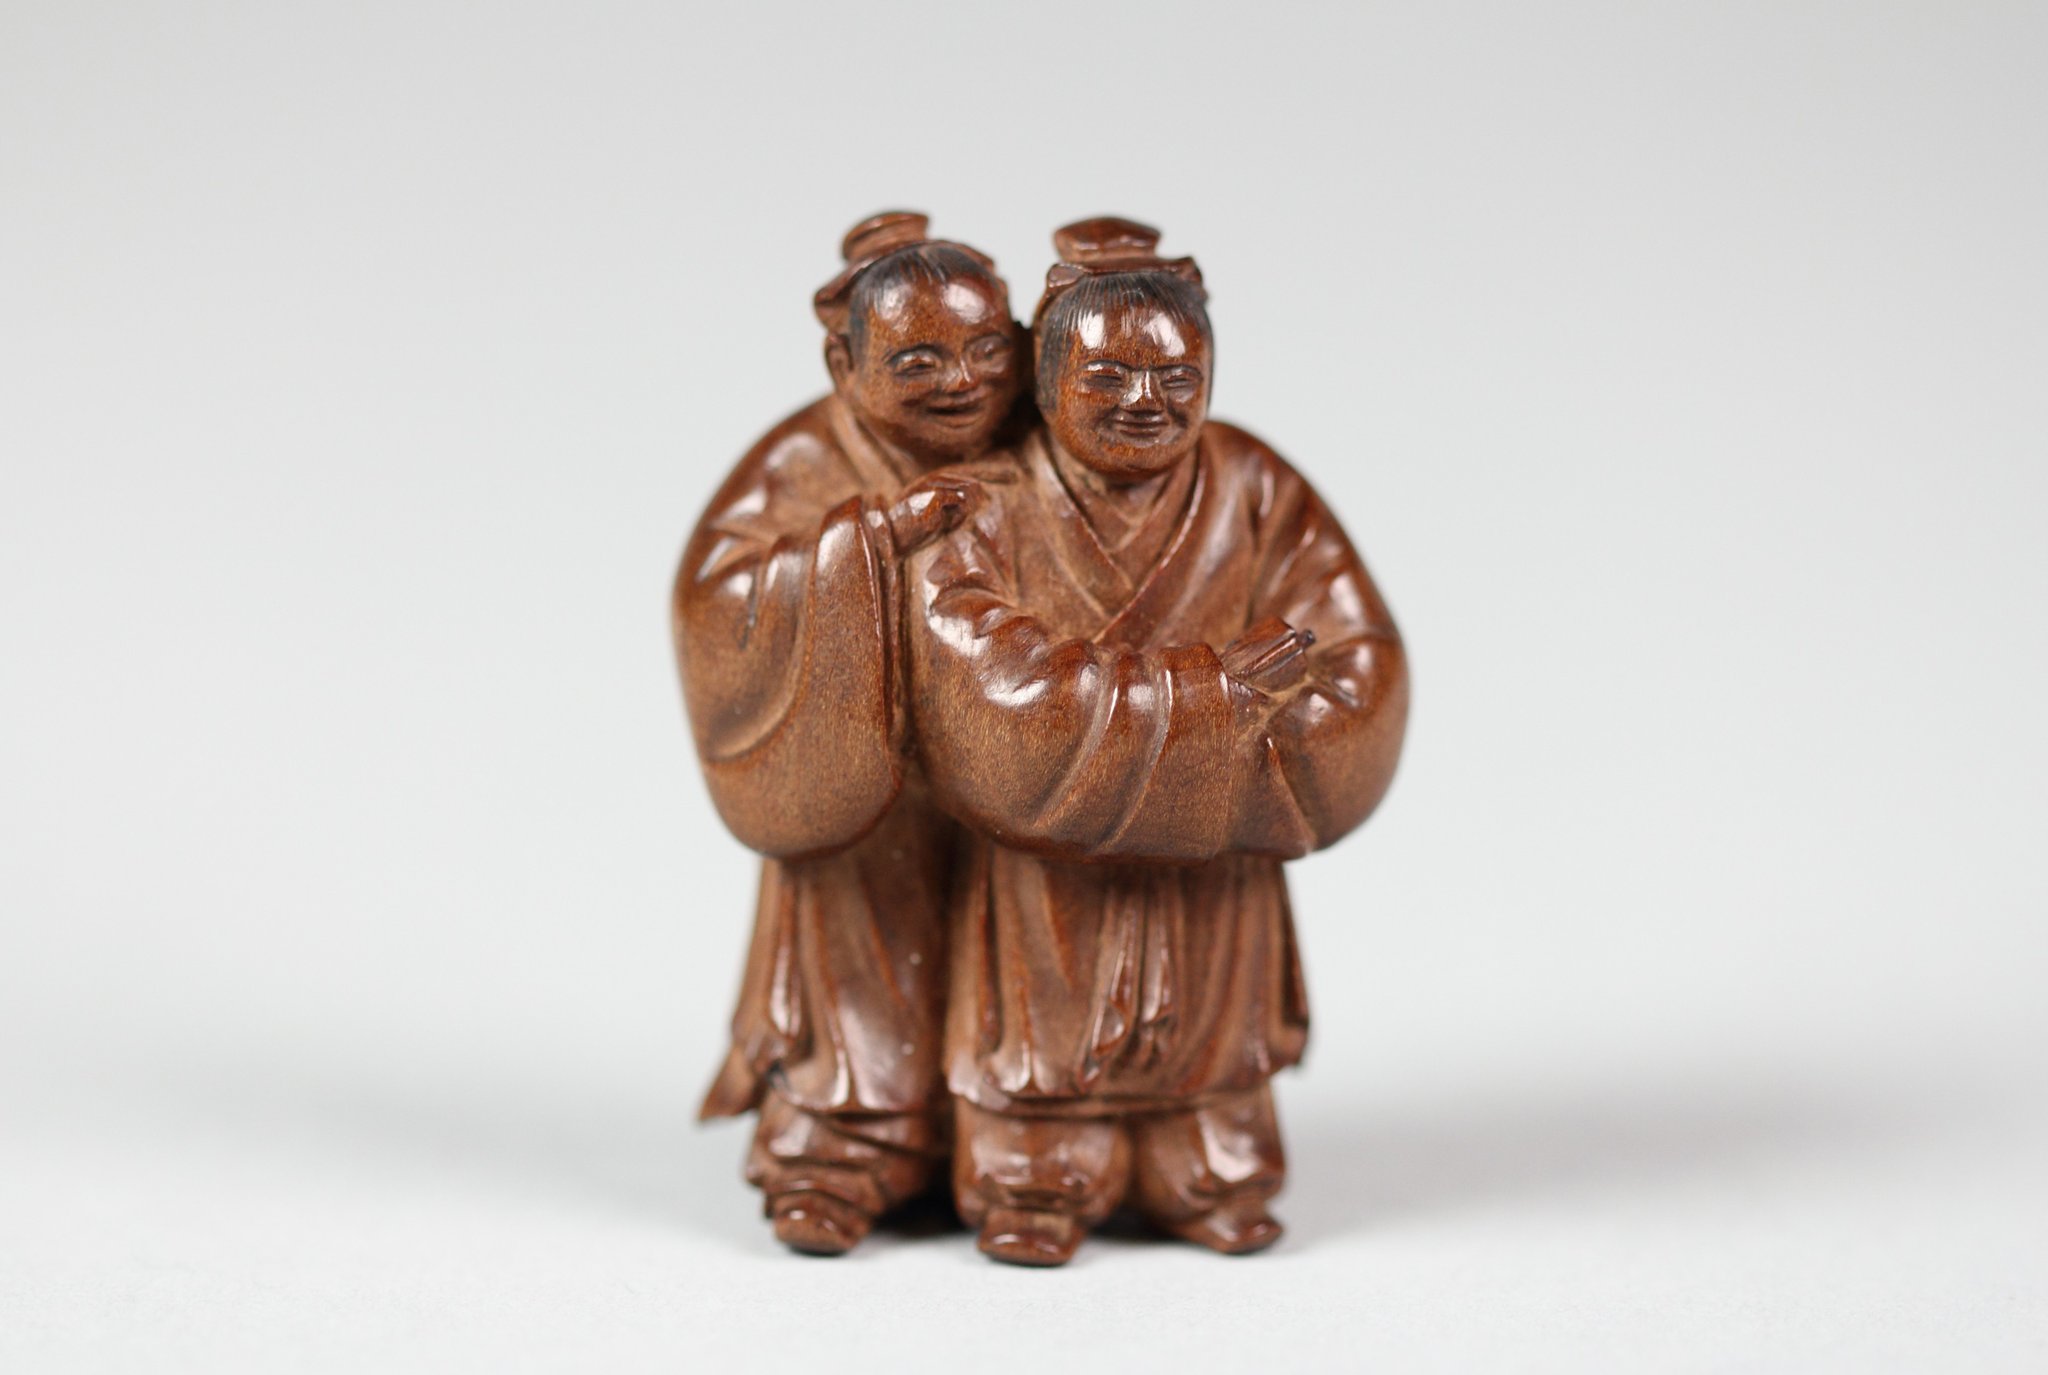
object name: netsuke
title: Netsuke of Two Figures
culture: japanese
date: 1801-1900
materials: wood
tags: men